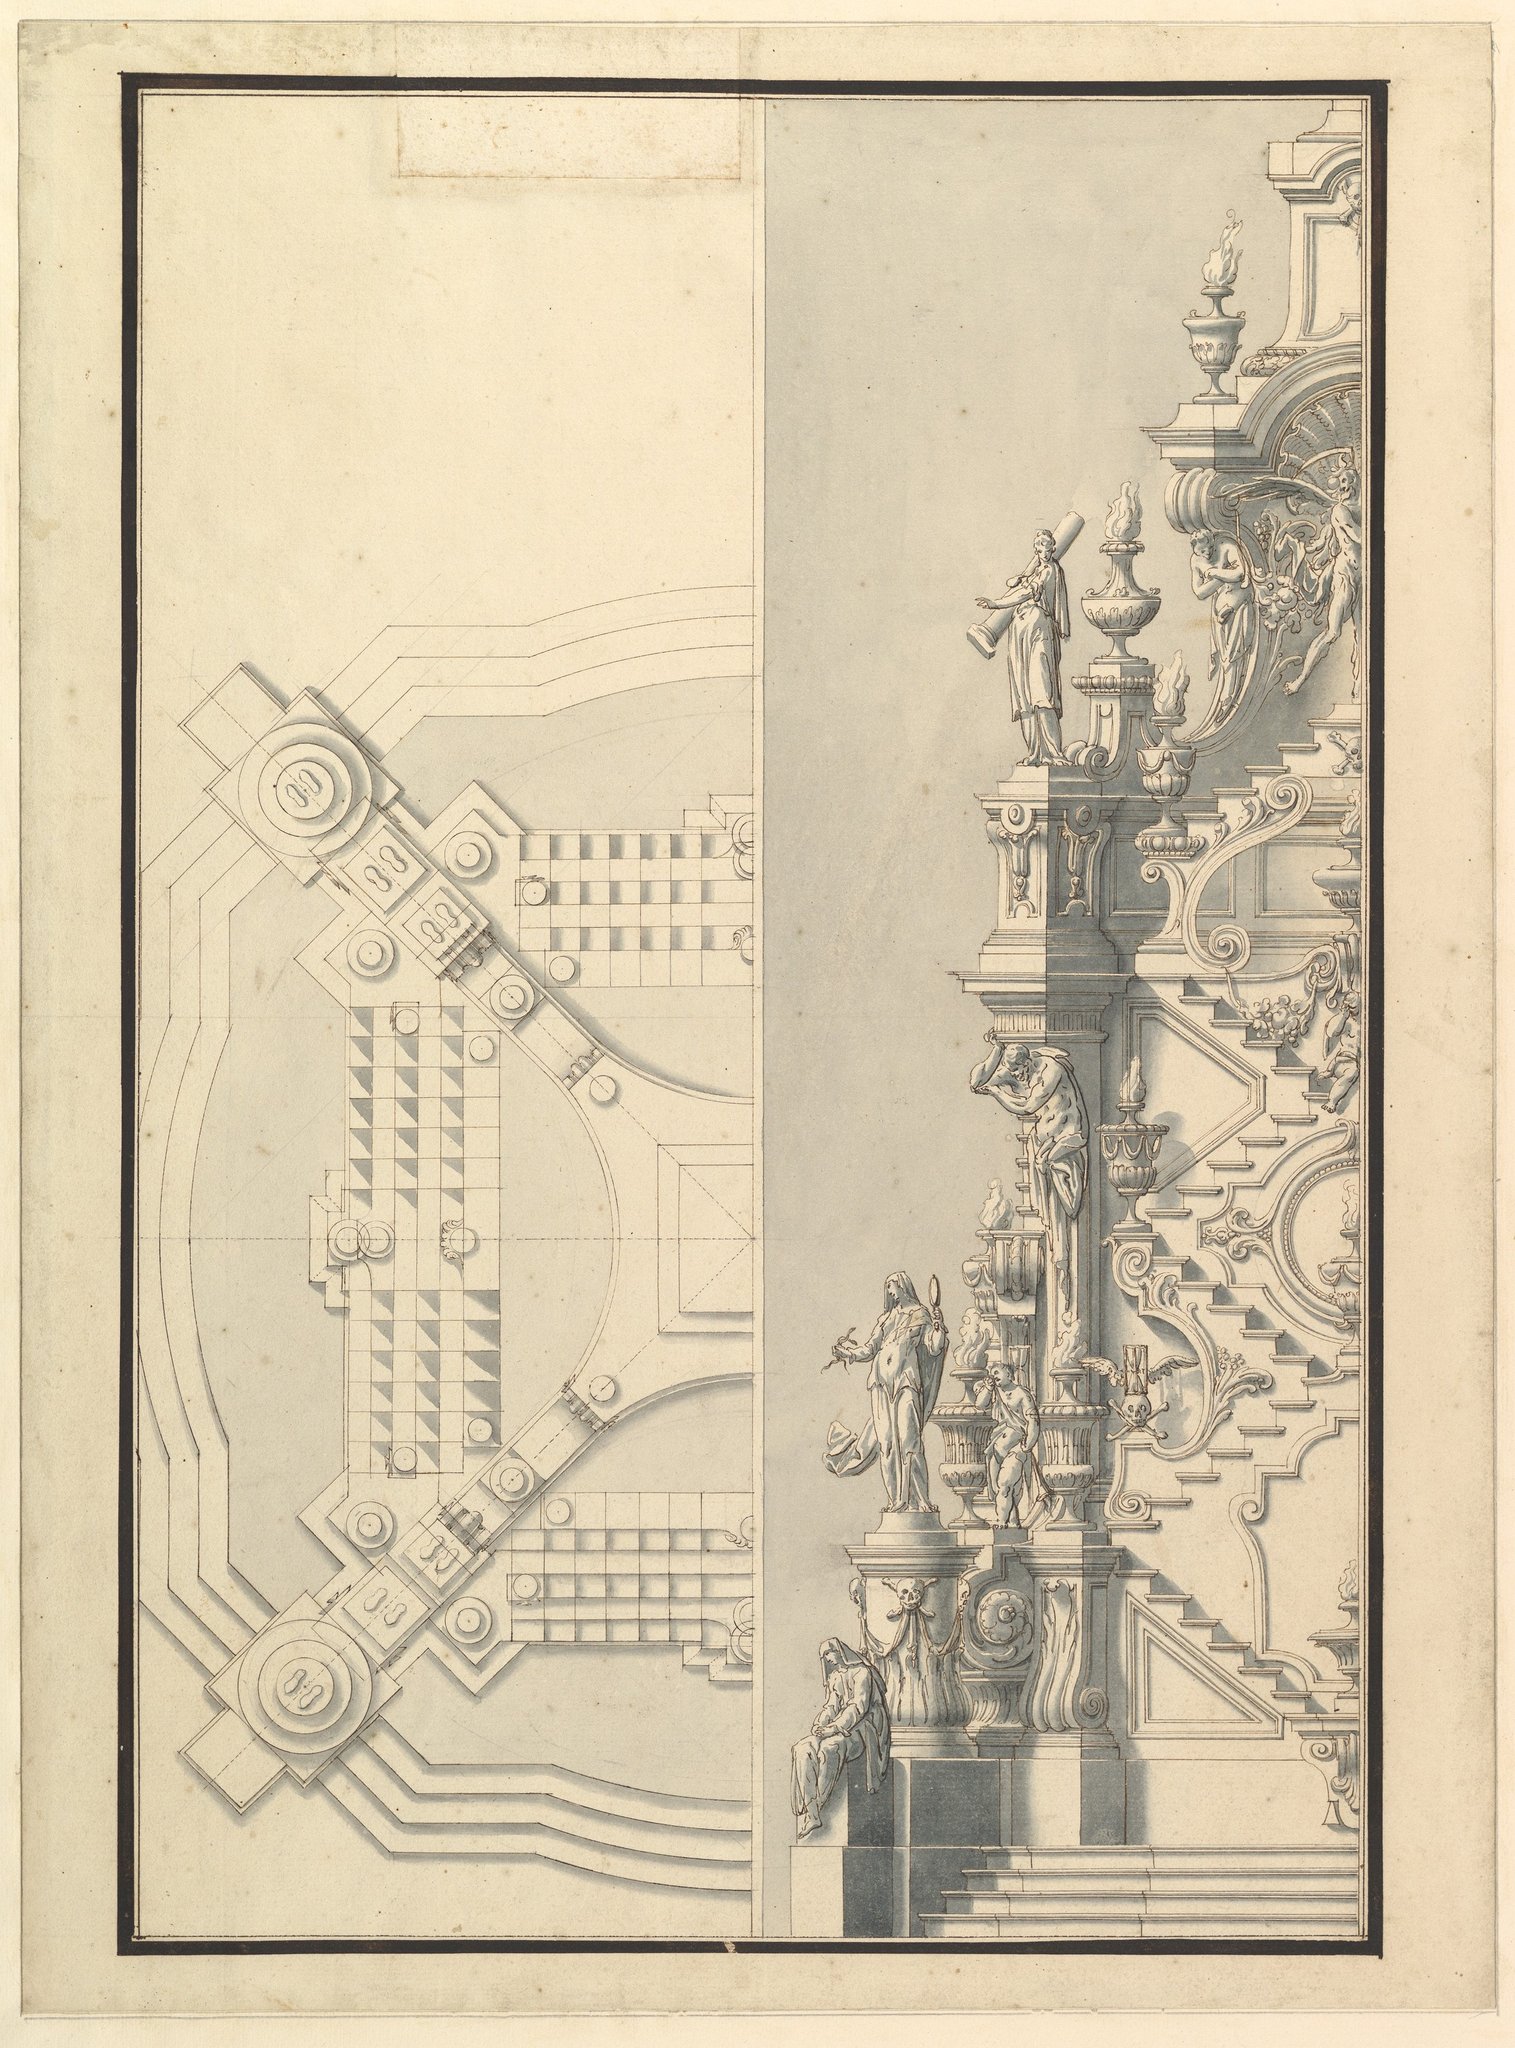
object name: drawing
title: Half Elevation and Half Ground Plan for a Catafalque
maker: giuseppe galli bibiena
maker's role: artist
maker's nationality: italian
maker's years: 1696-1756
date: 1696-1756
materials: ink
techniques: pen, wash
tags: architecture